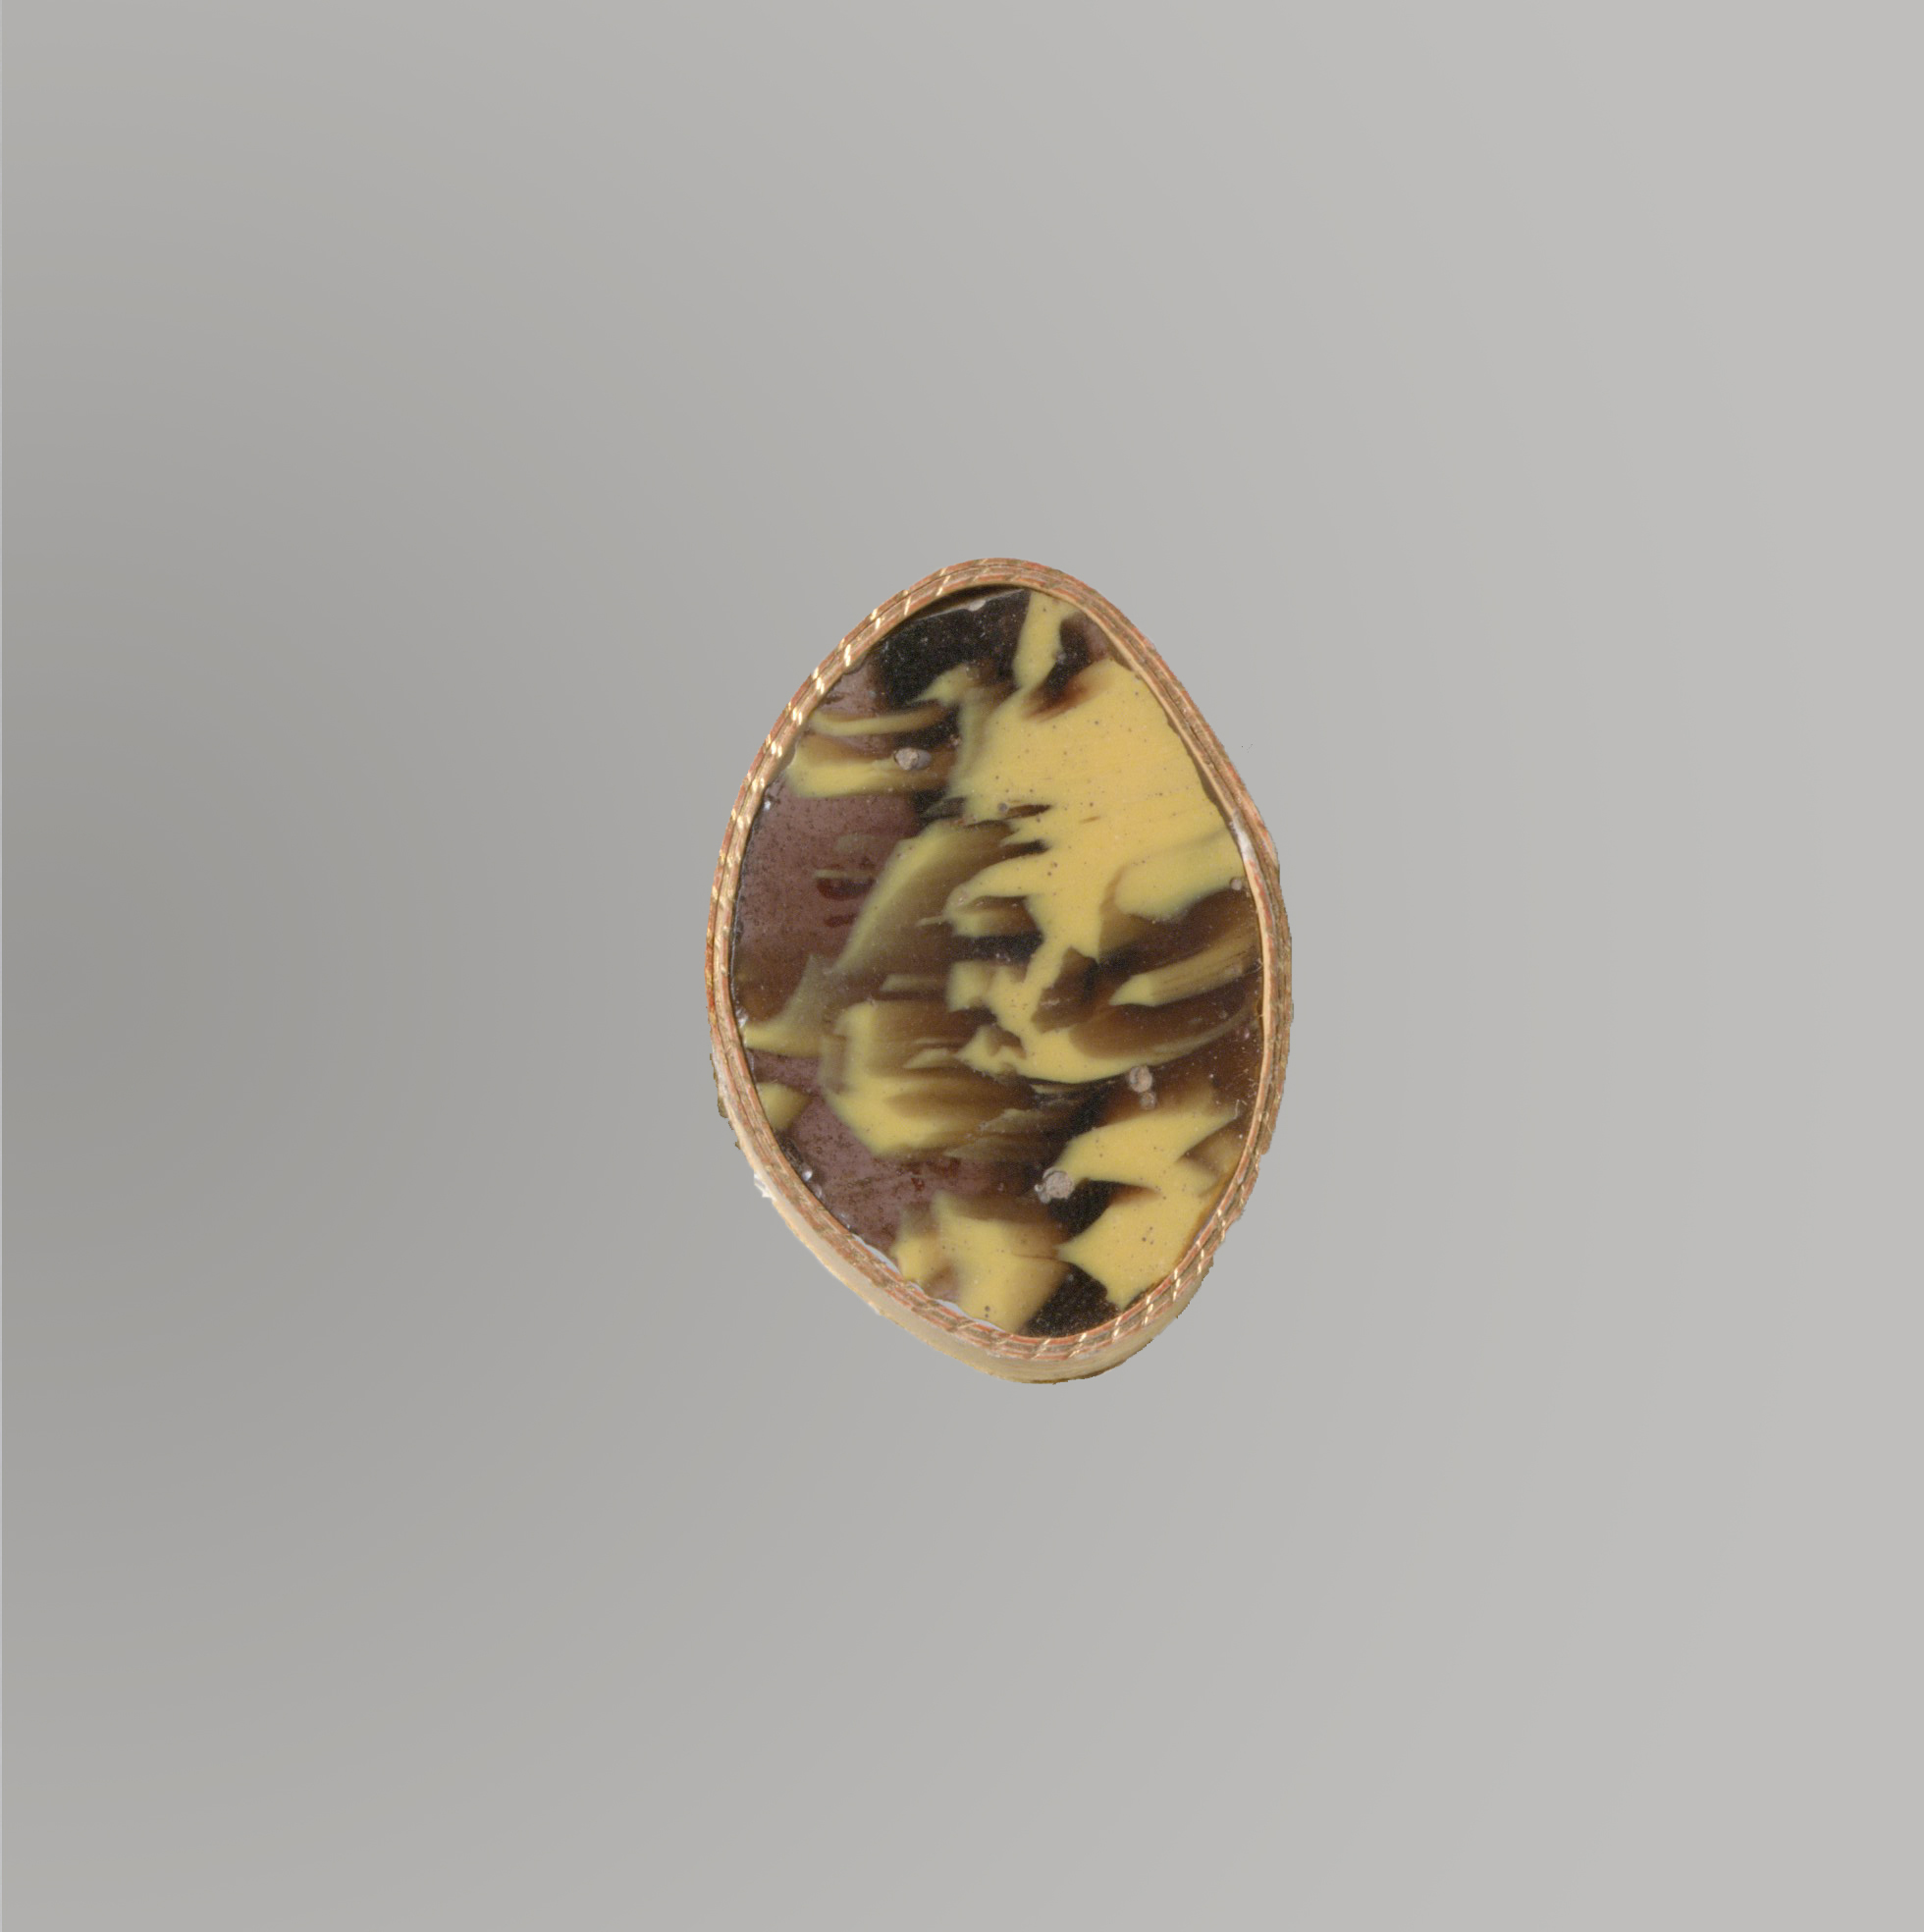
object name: fragment, mosaic bowl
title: Glass mosaic ribbed bowl fragment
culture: roman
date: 34 BCE-33 CE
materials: glass